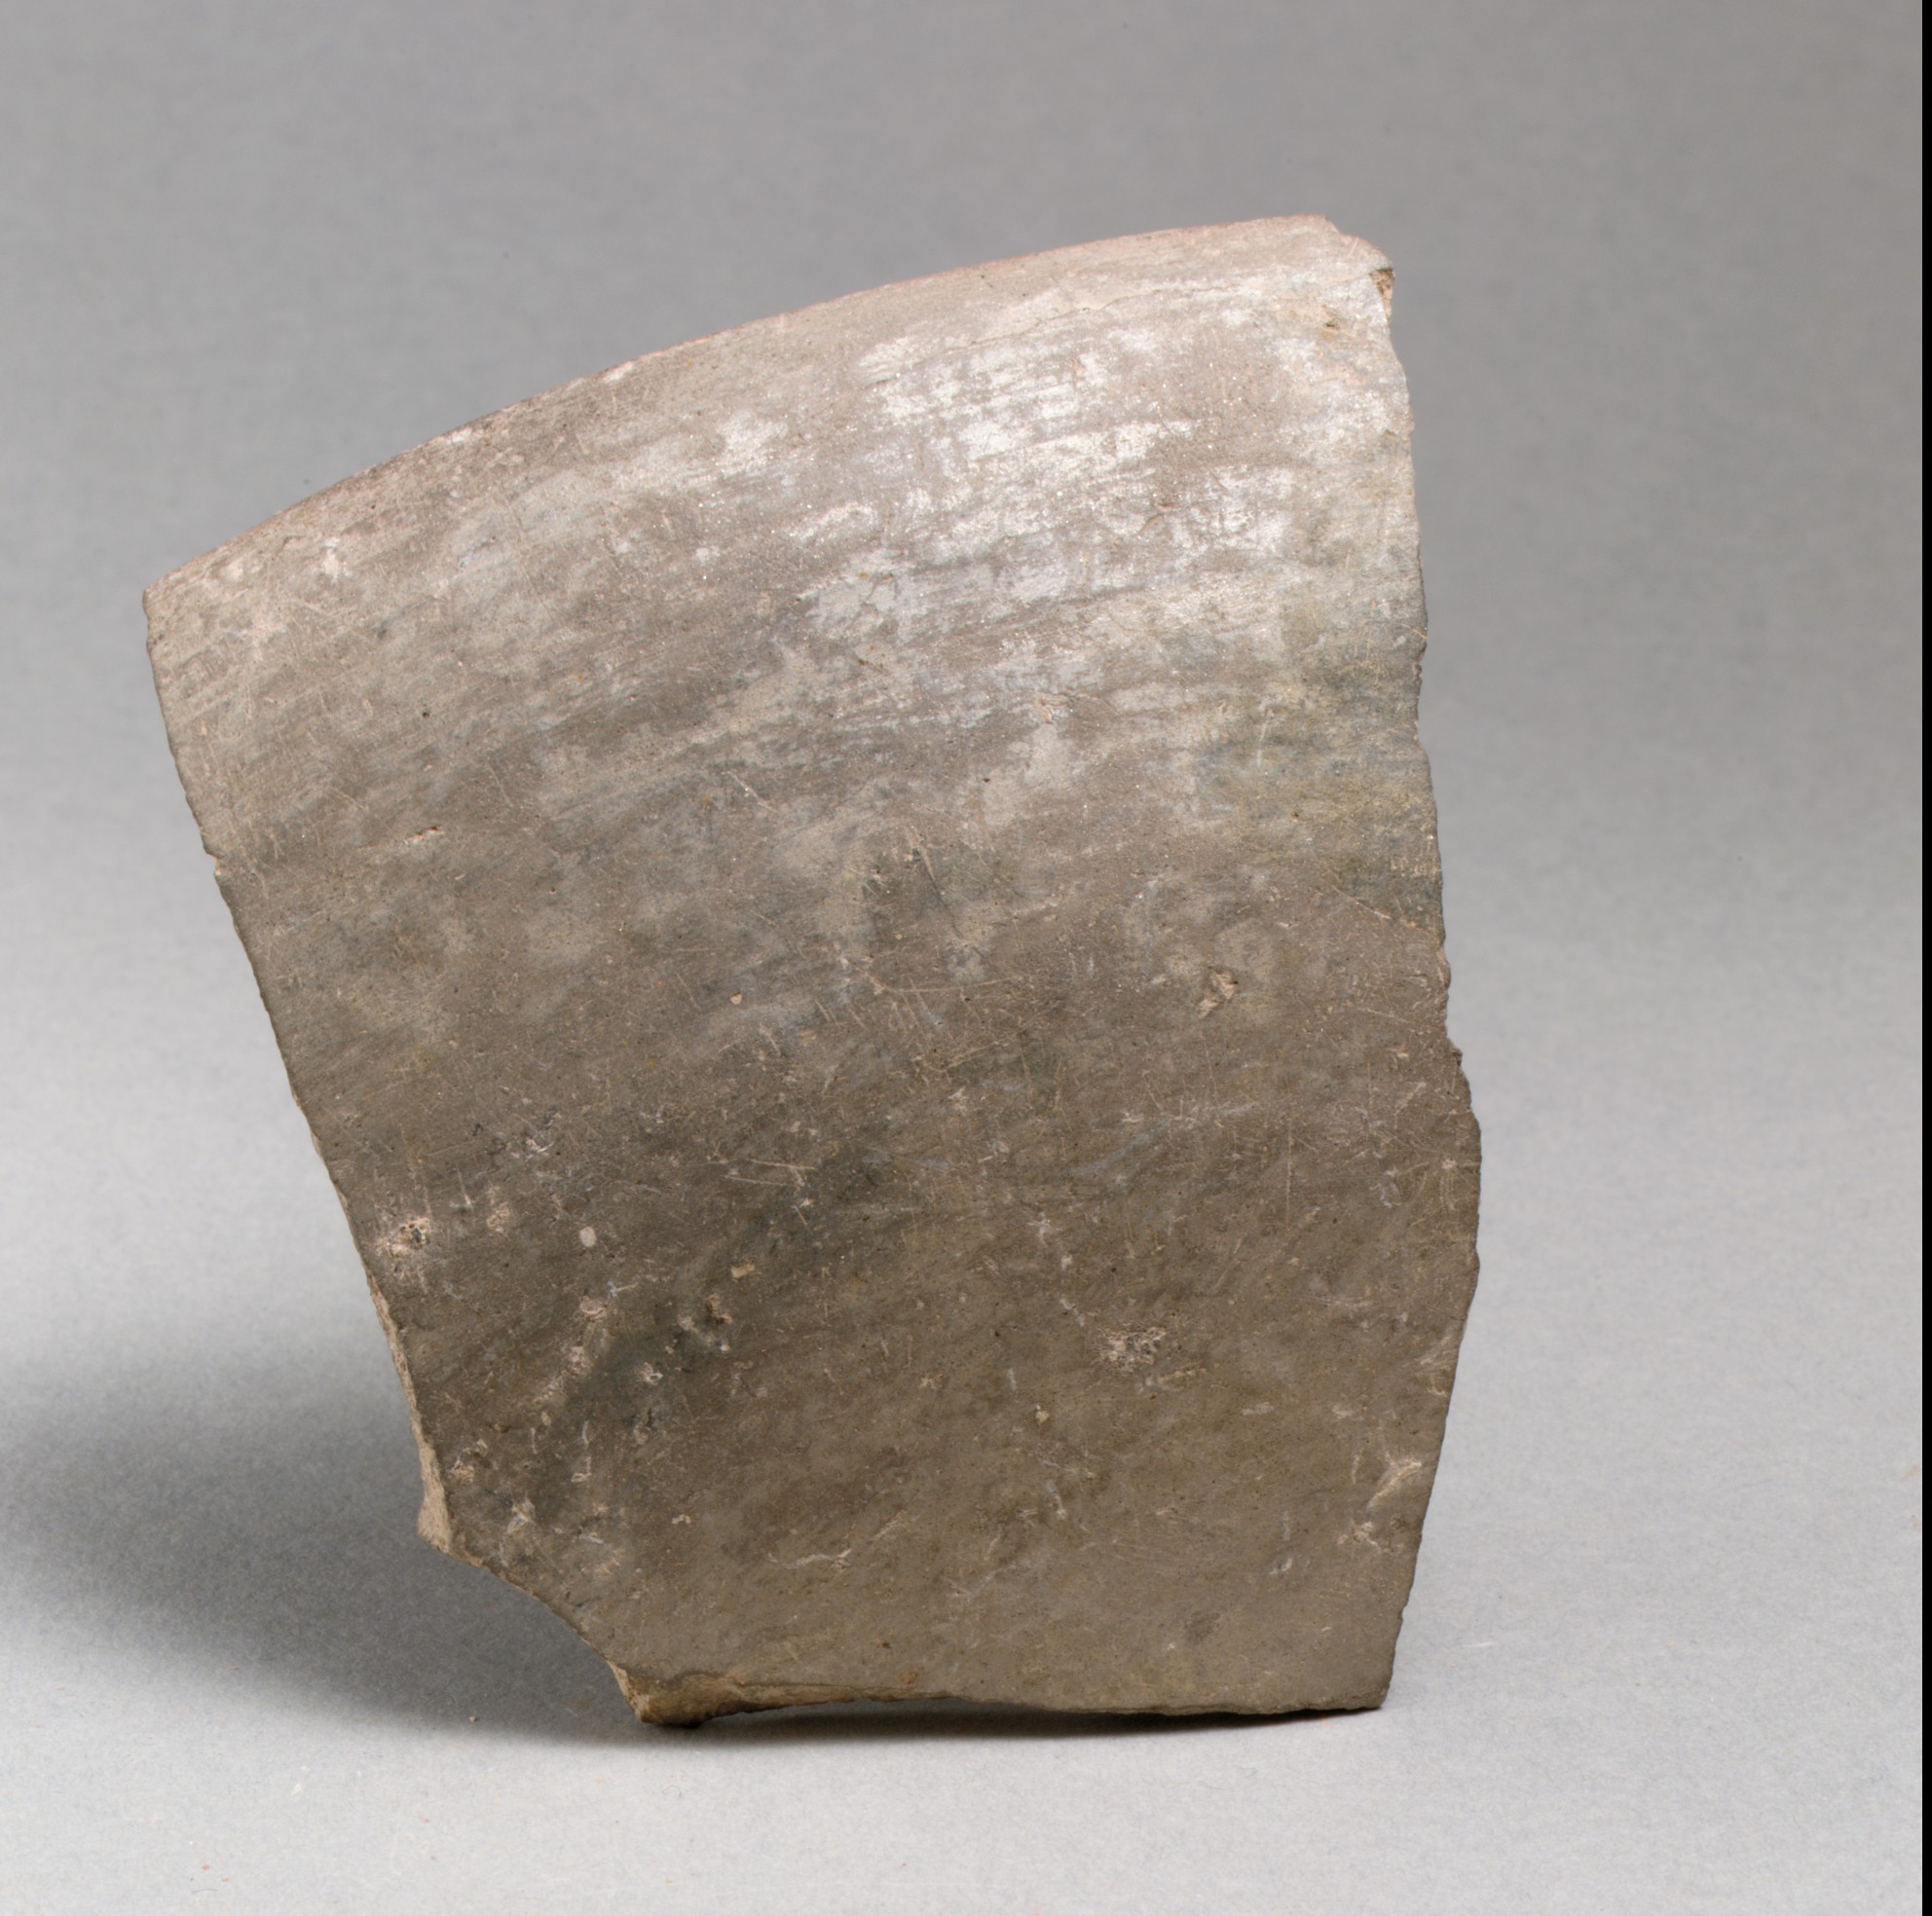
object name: vase fragment, 3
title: Vase fragments, 3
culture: greek or lydian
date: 900-30 BCE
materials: terracotta